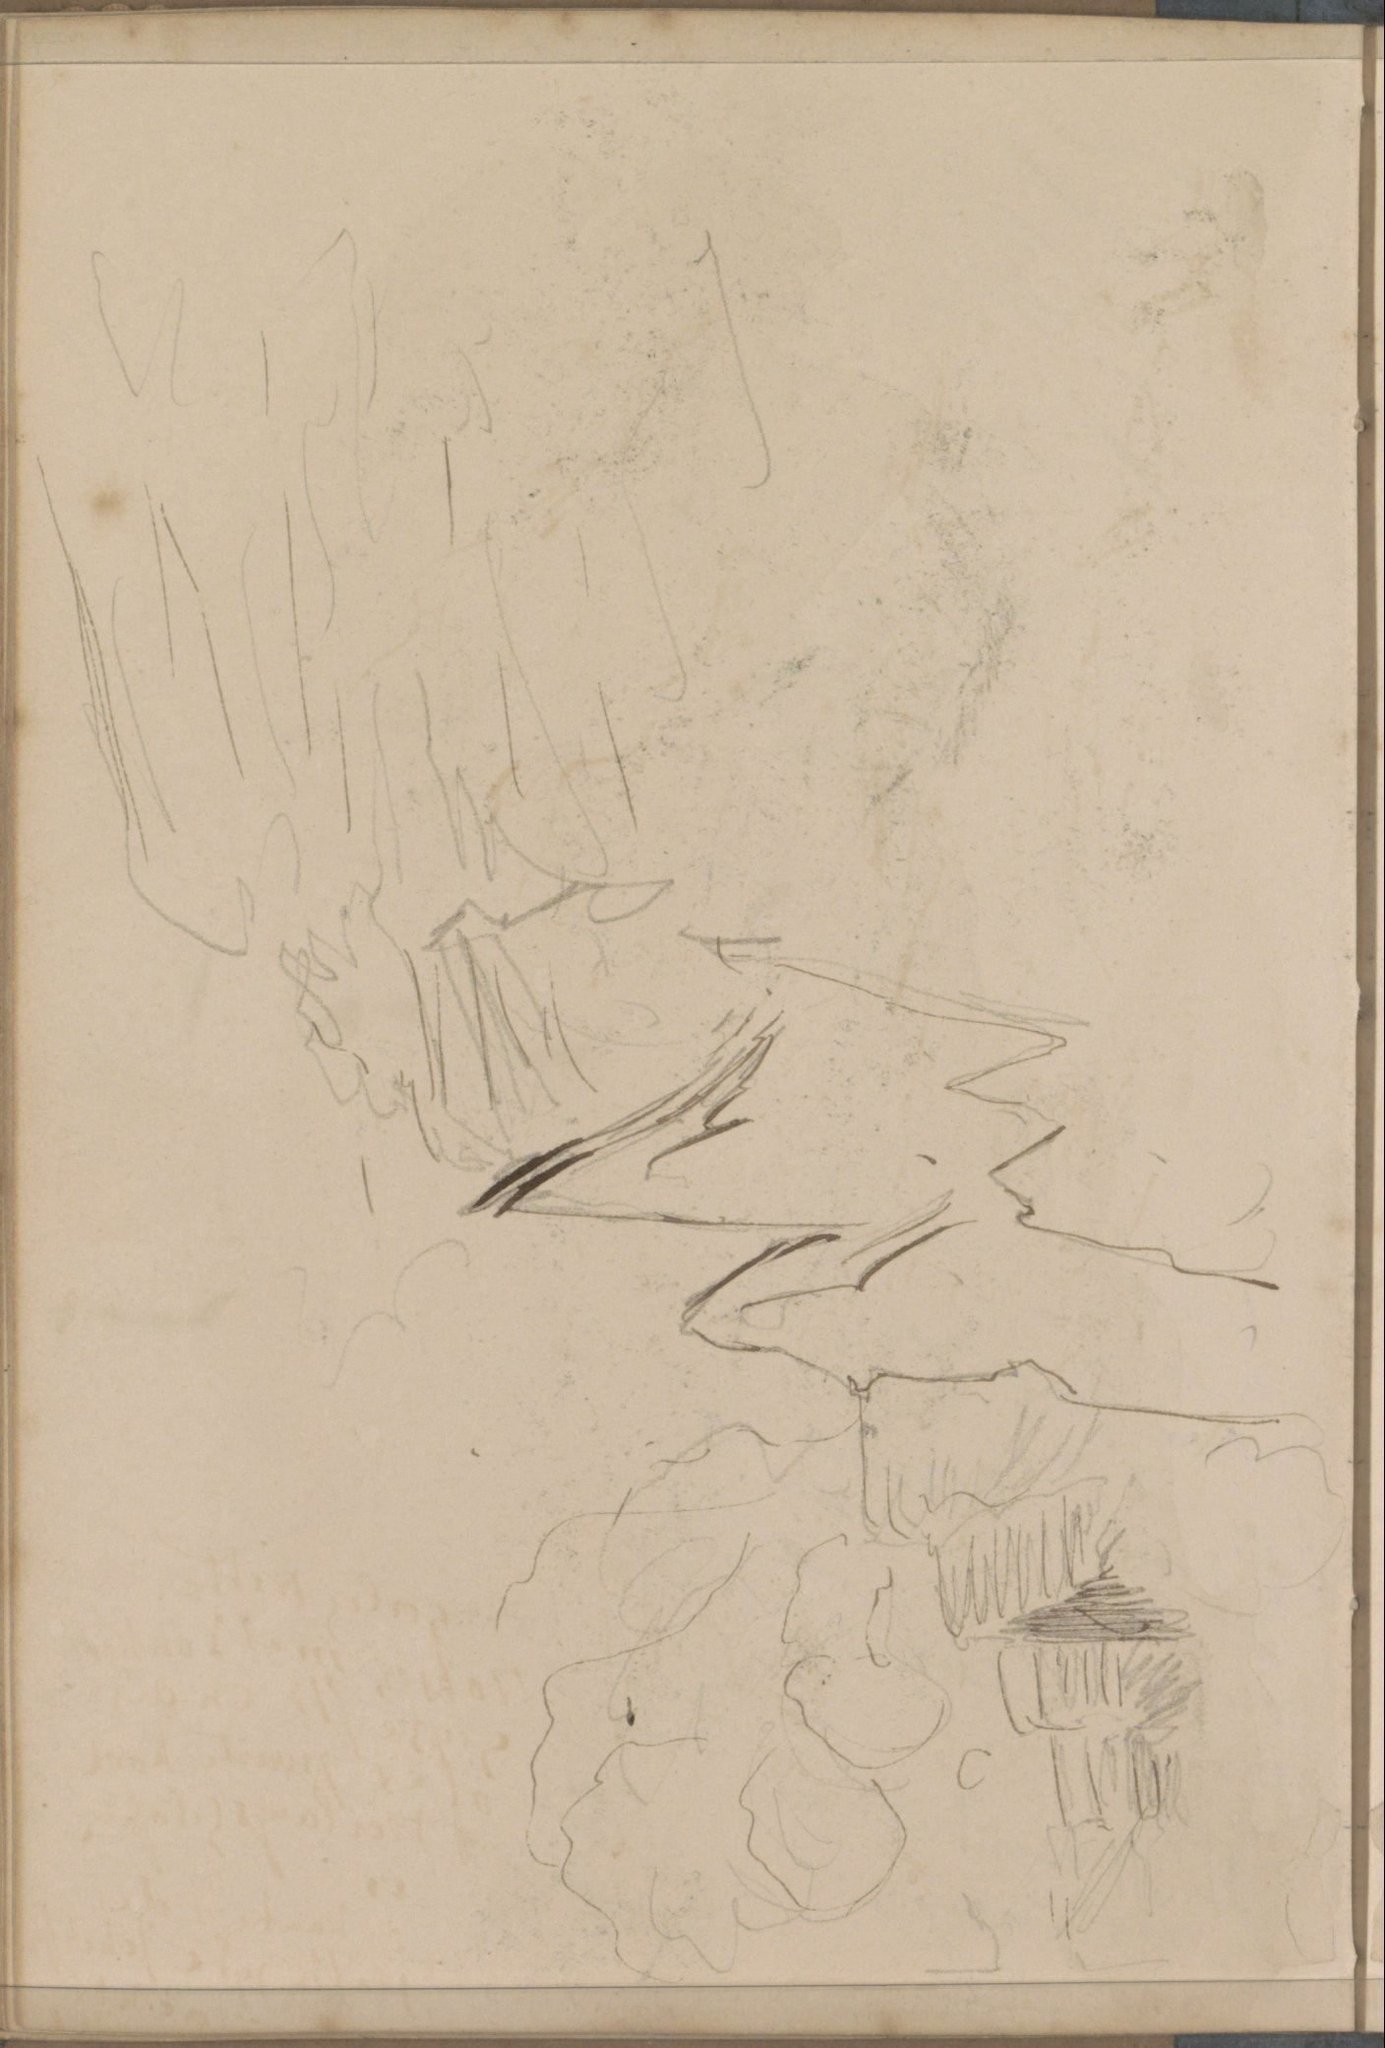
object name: sketchbook leaf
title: Waterval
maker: johannes tavenraat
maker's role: draughtsman, painter, print maker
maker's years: 1809-1881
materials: ink, paper, pencil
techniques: pen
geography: krimml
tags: waterfall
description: Blad 22 verso uit een schetsboek met 47 bladen.